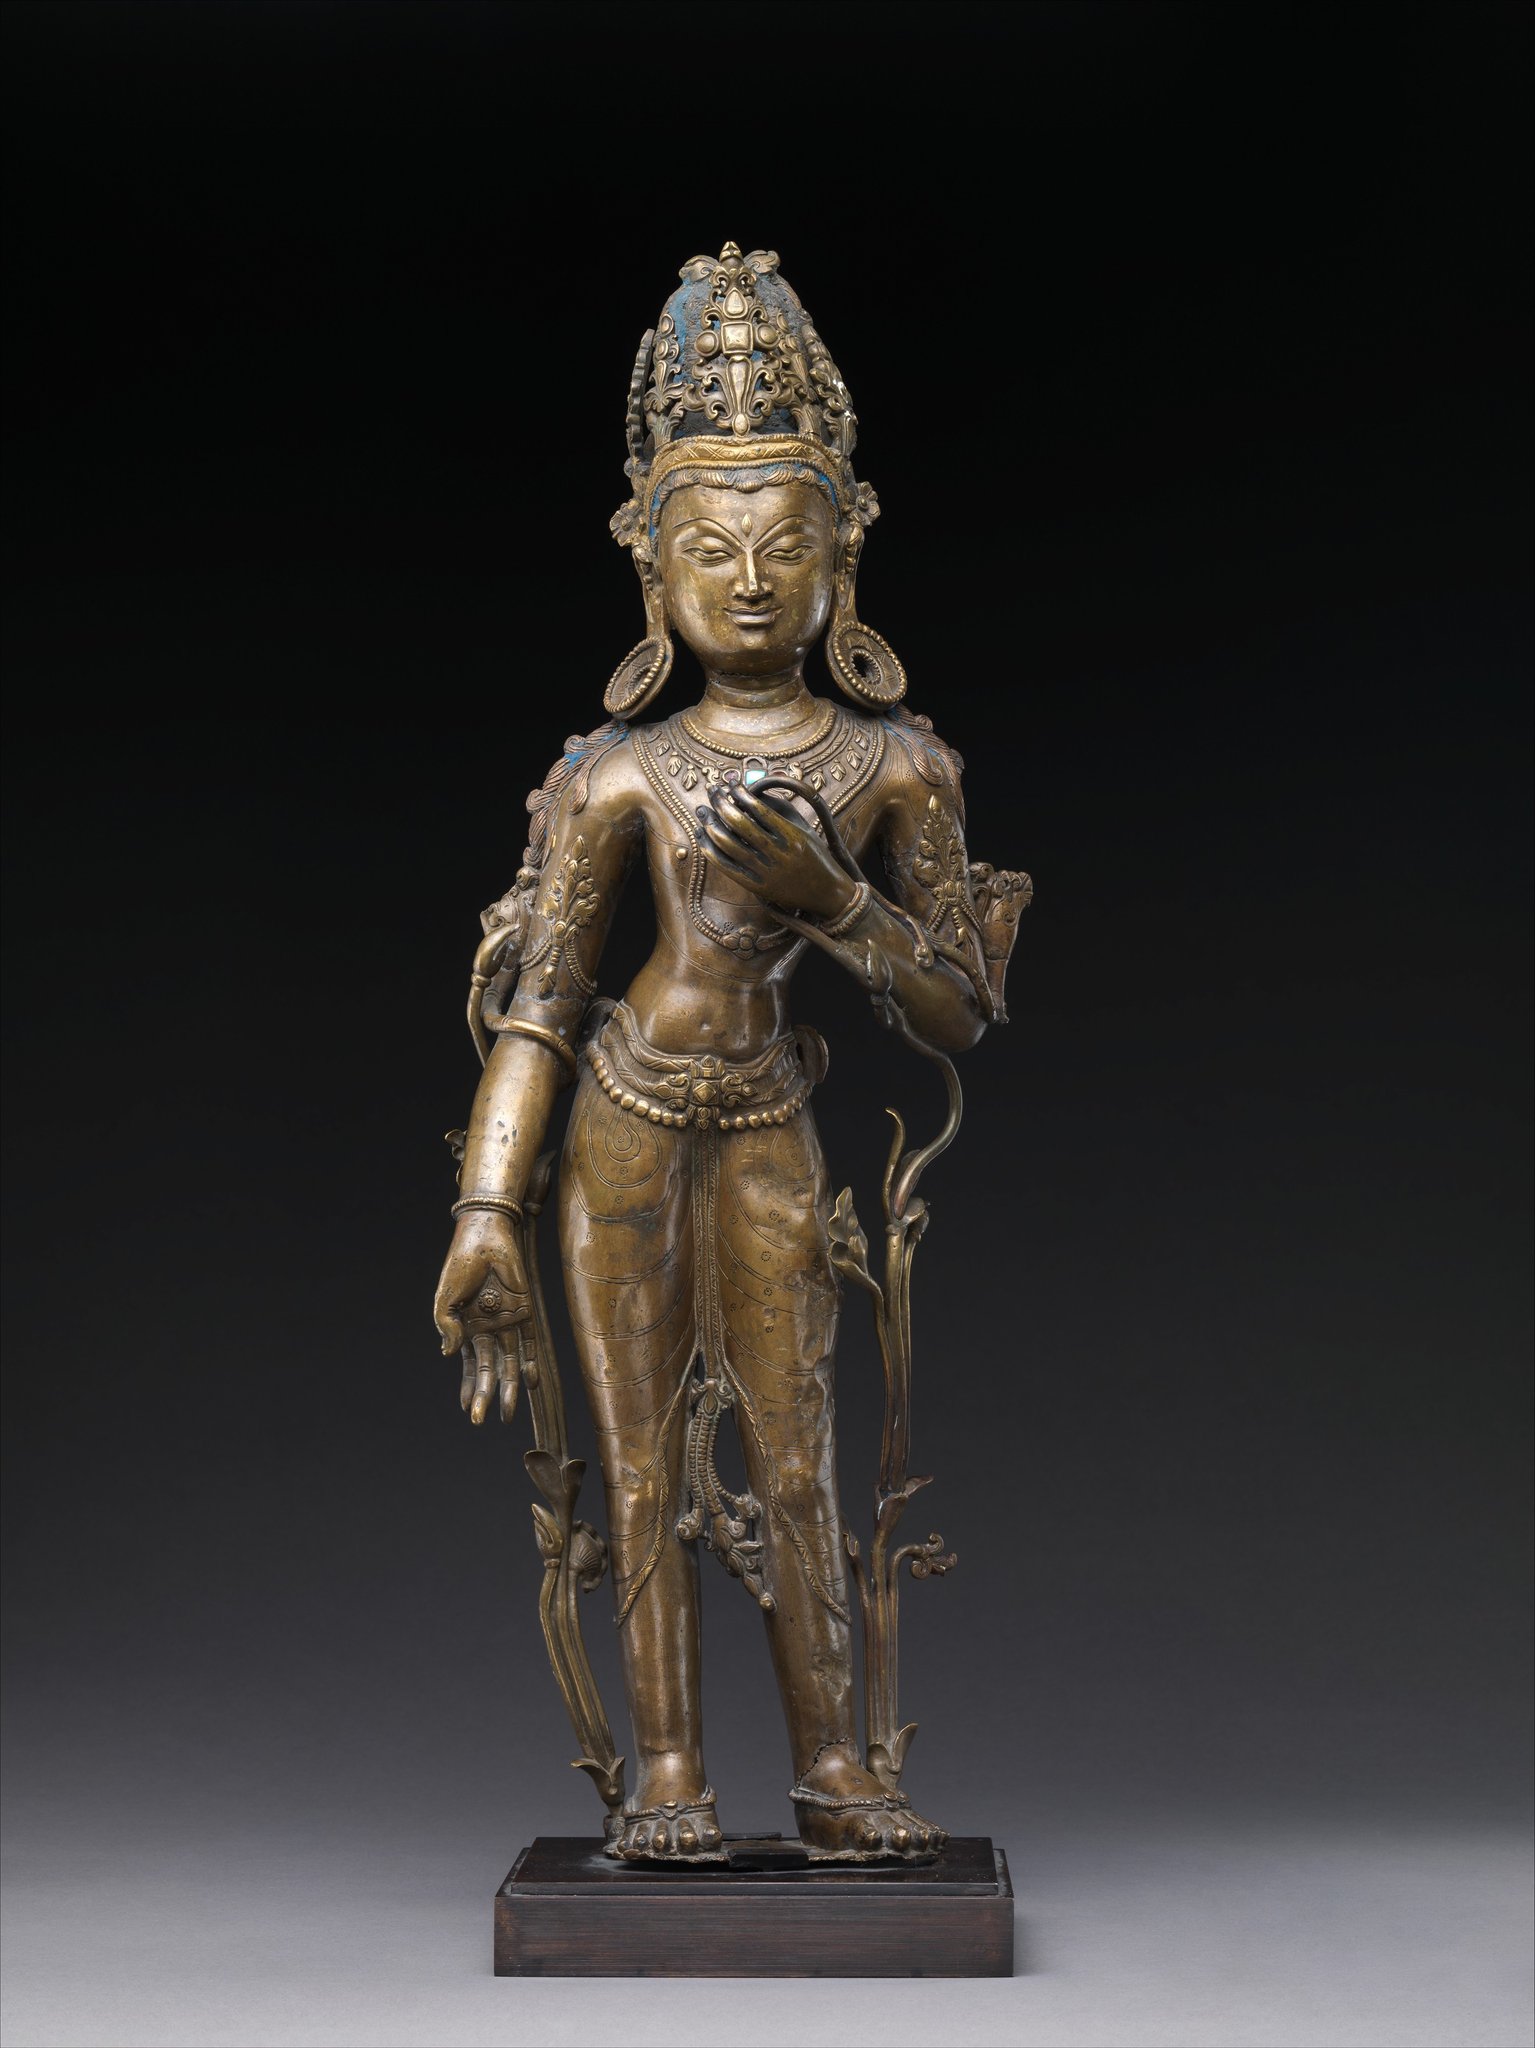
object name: figure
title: The Bodhisattva Avalokiteshvara in the Form of Padmapani, the Lotus Bearer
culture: tibetan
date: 1101-1200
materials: bronze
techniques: inlay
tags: buddhism,avalokiteshvara,bodhisattvas